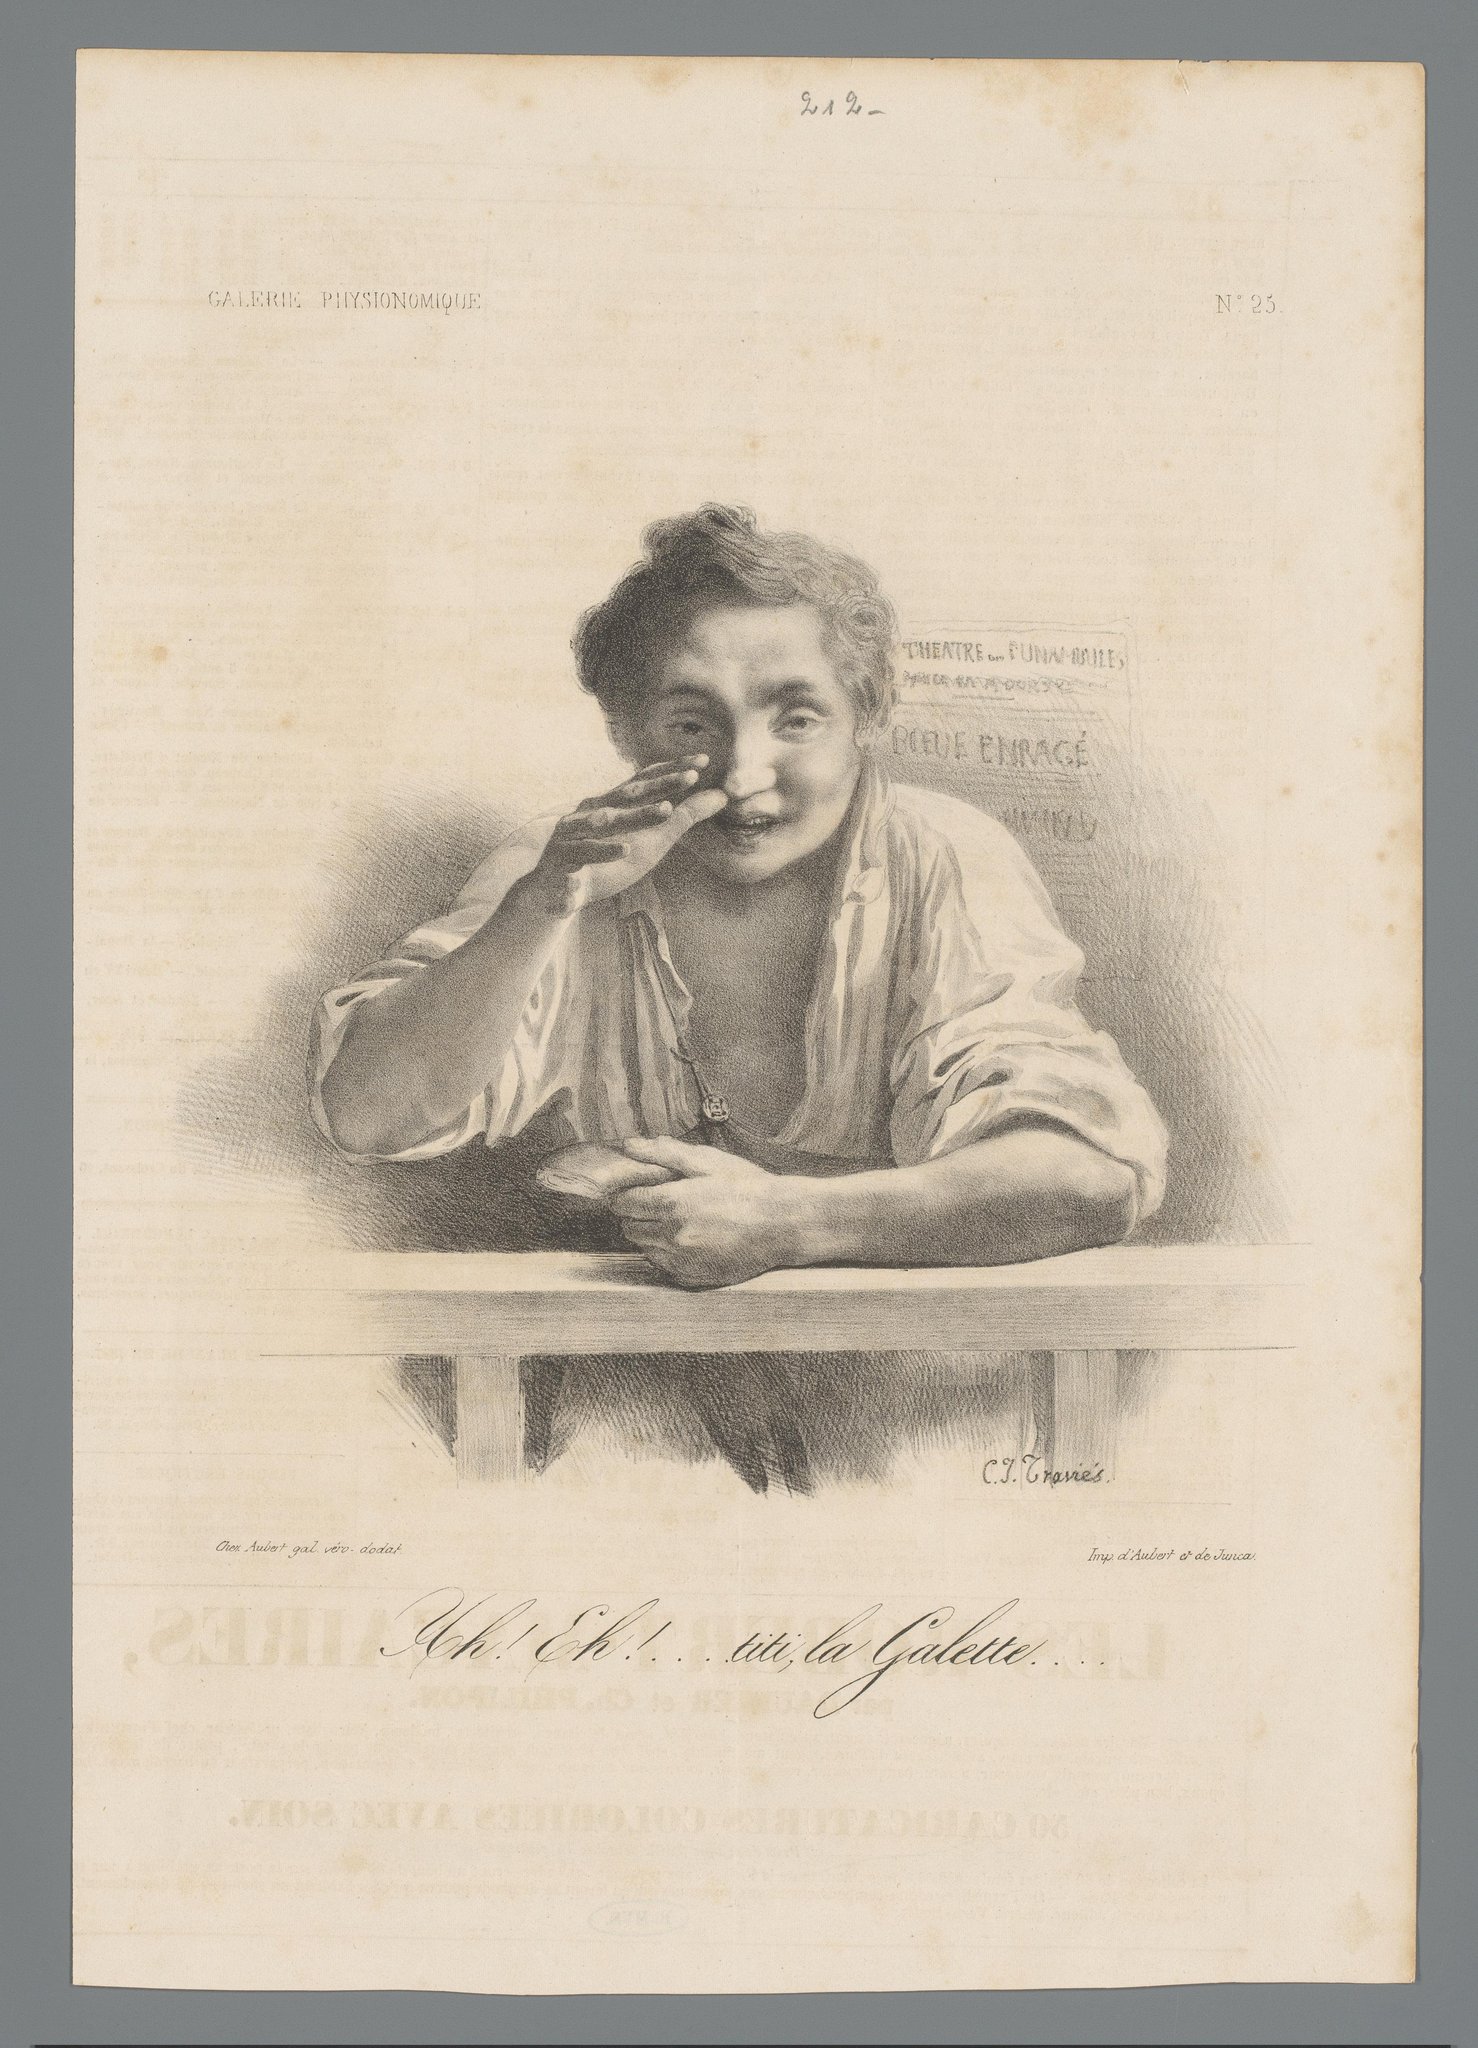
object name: print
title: Ah! Eh!... titi, la galette...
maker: charles-joseph traviès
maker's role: print maker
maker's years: 1804-1859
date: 1837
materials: paper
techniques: letterpress printing, lithograph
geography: paris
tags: adult man, mocking, insulting; teasing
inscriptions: collector's mark: Lugt 2228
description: Prent uit: Le Charivari 6 (1837), nr. 271, 28 september 1837.